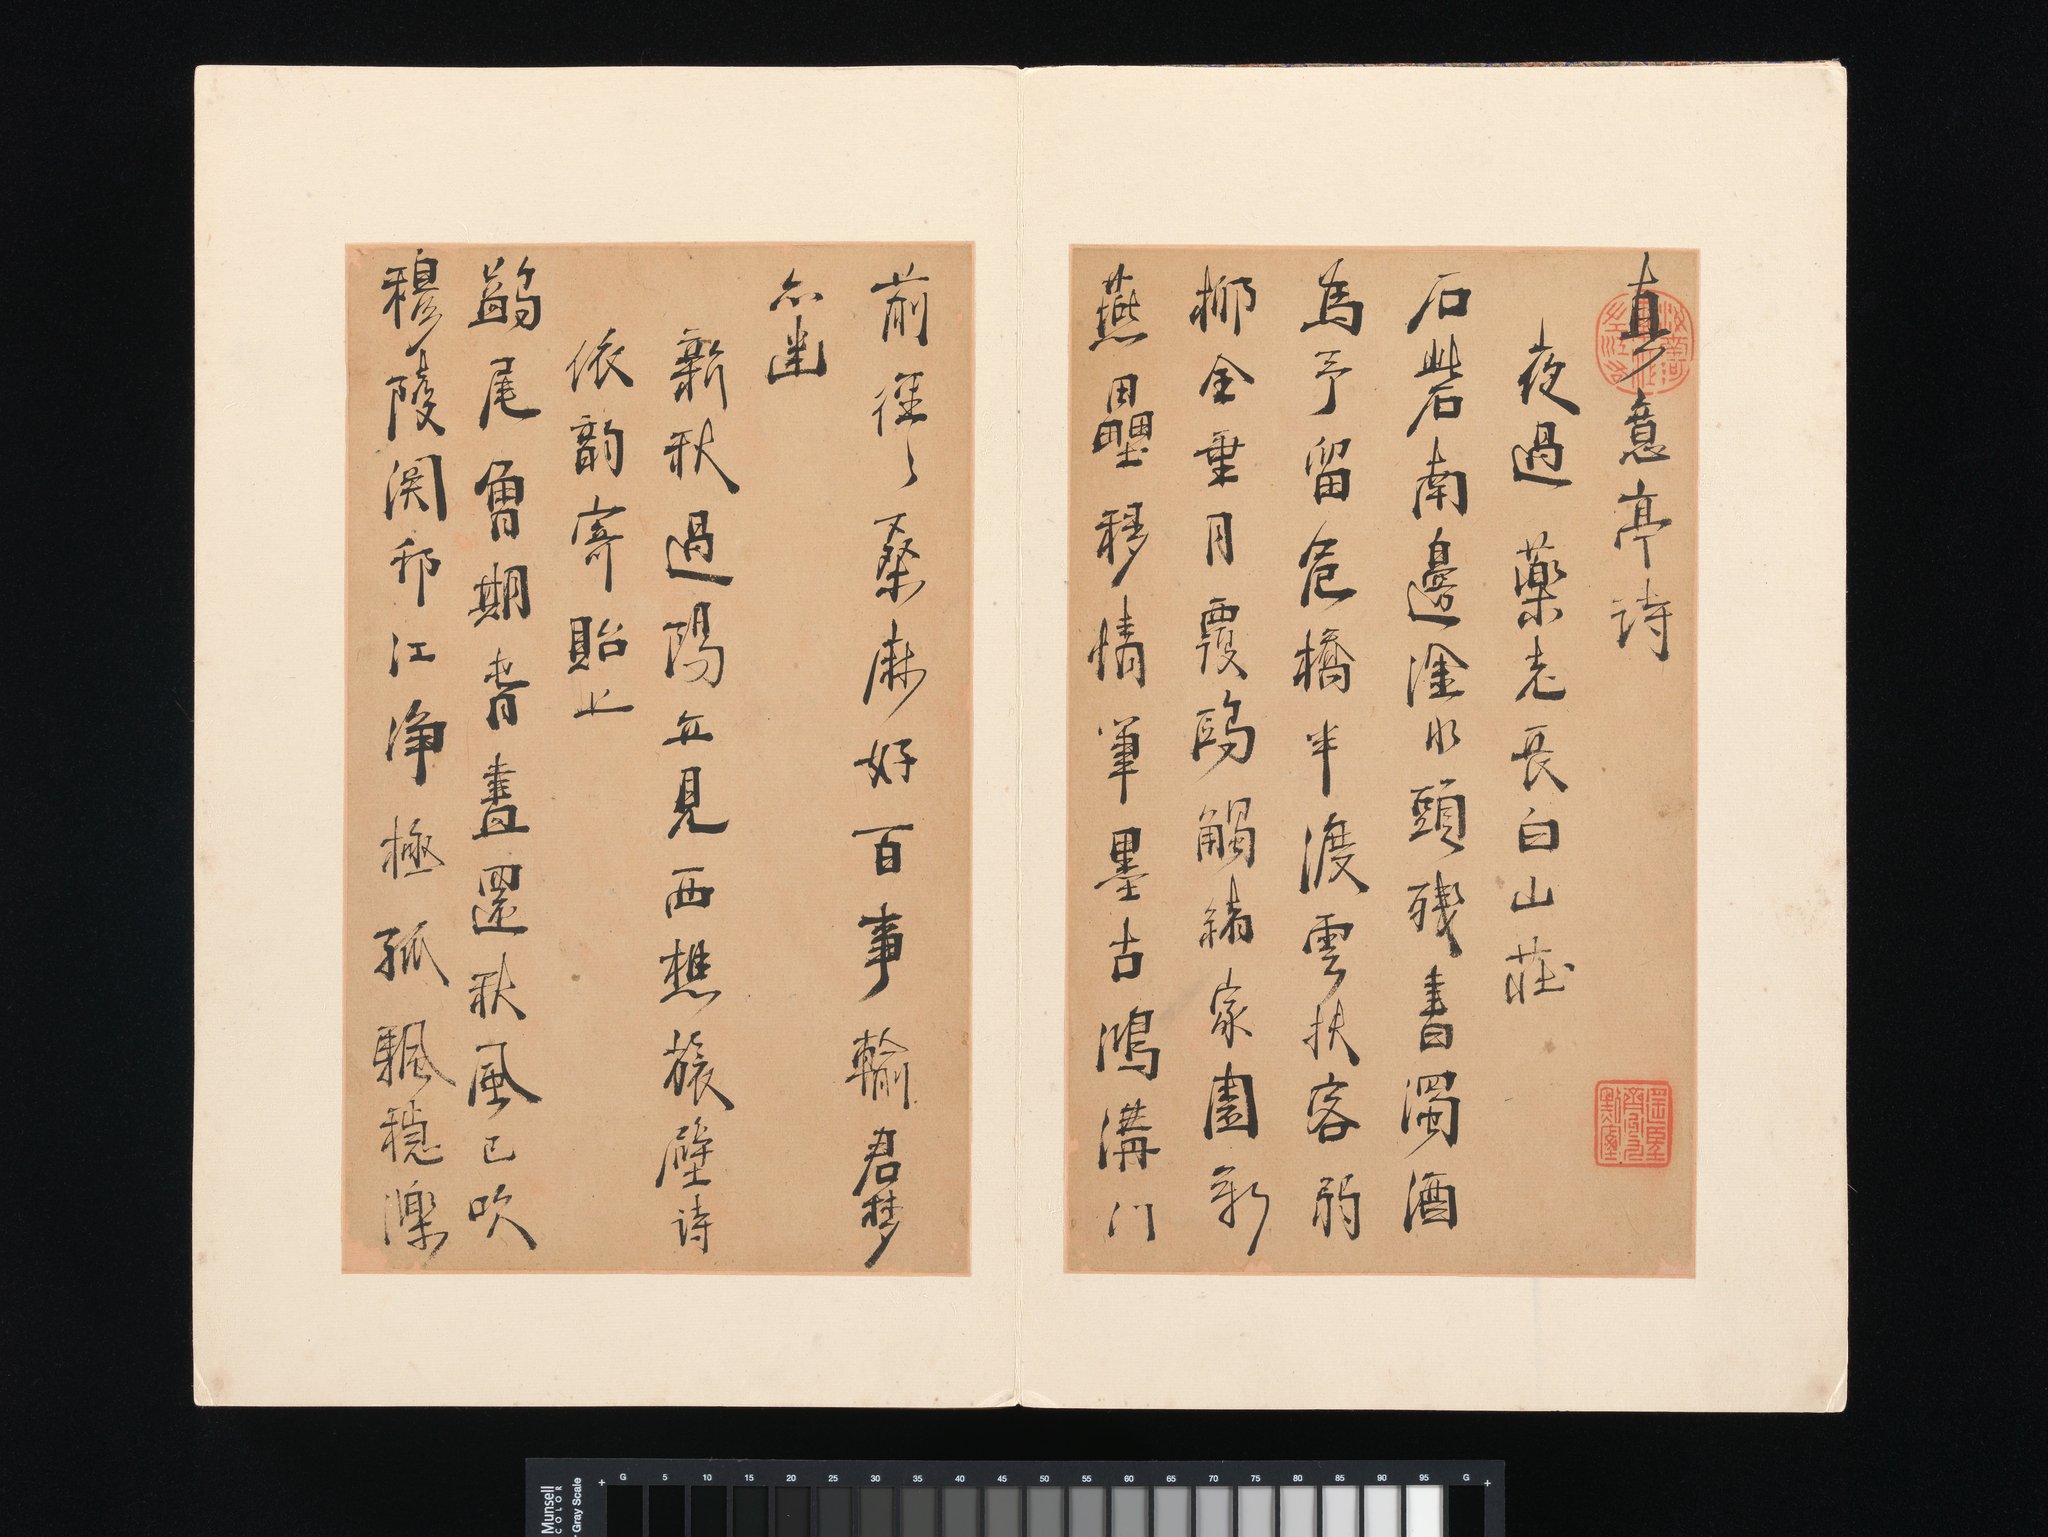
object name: album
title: Poems from the Pavilion of Fundamental Truth (Zhenyi Ting)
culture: chinese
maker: zhou lianggong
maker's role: artist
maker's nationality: chinese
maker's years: 1612-1672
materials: ink, paper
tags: poetry,calligraphy